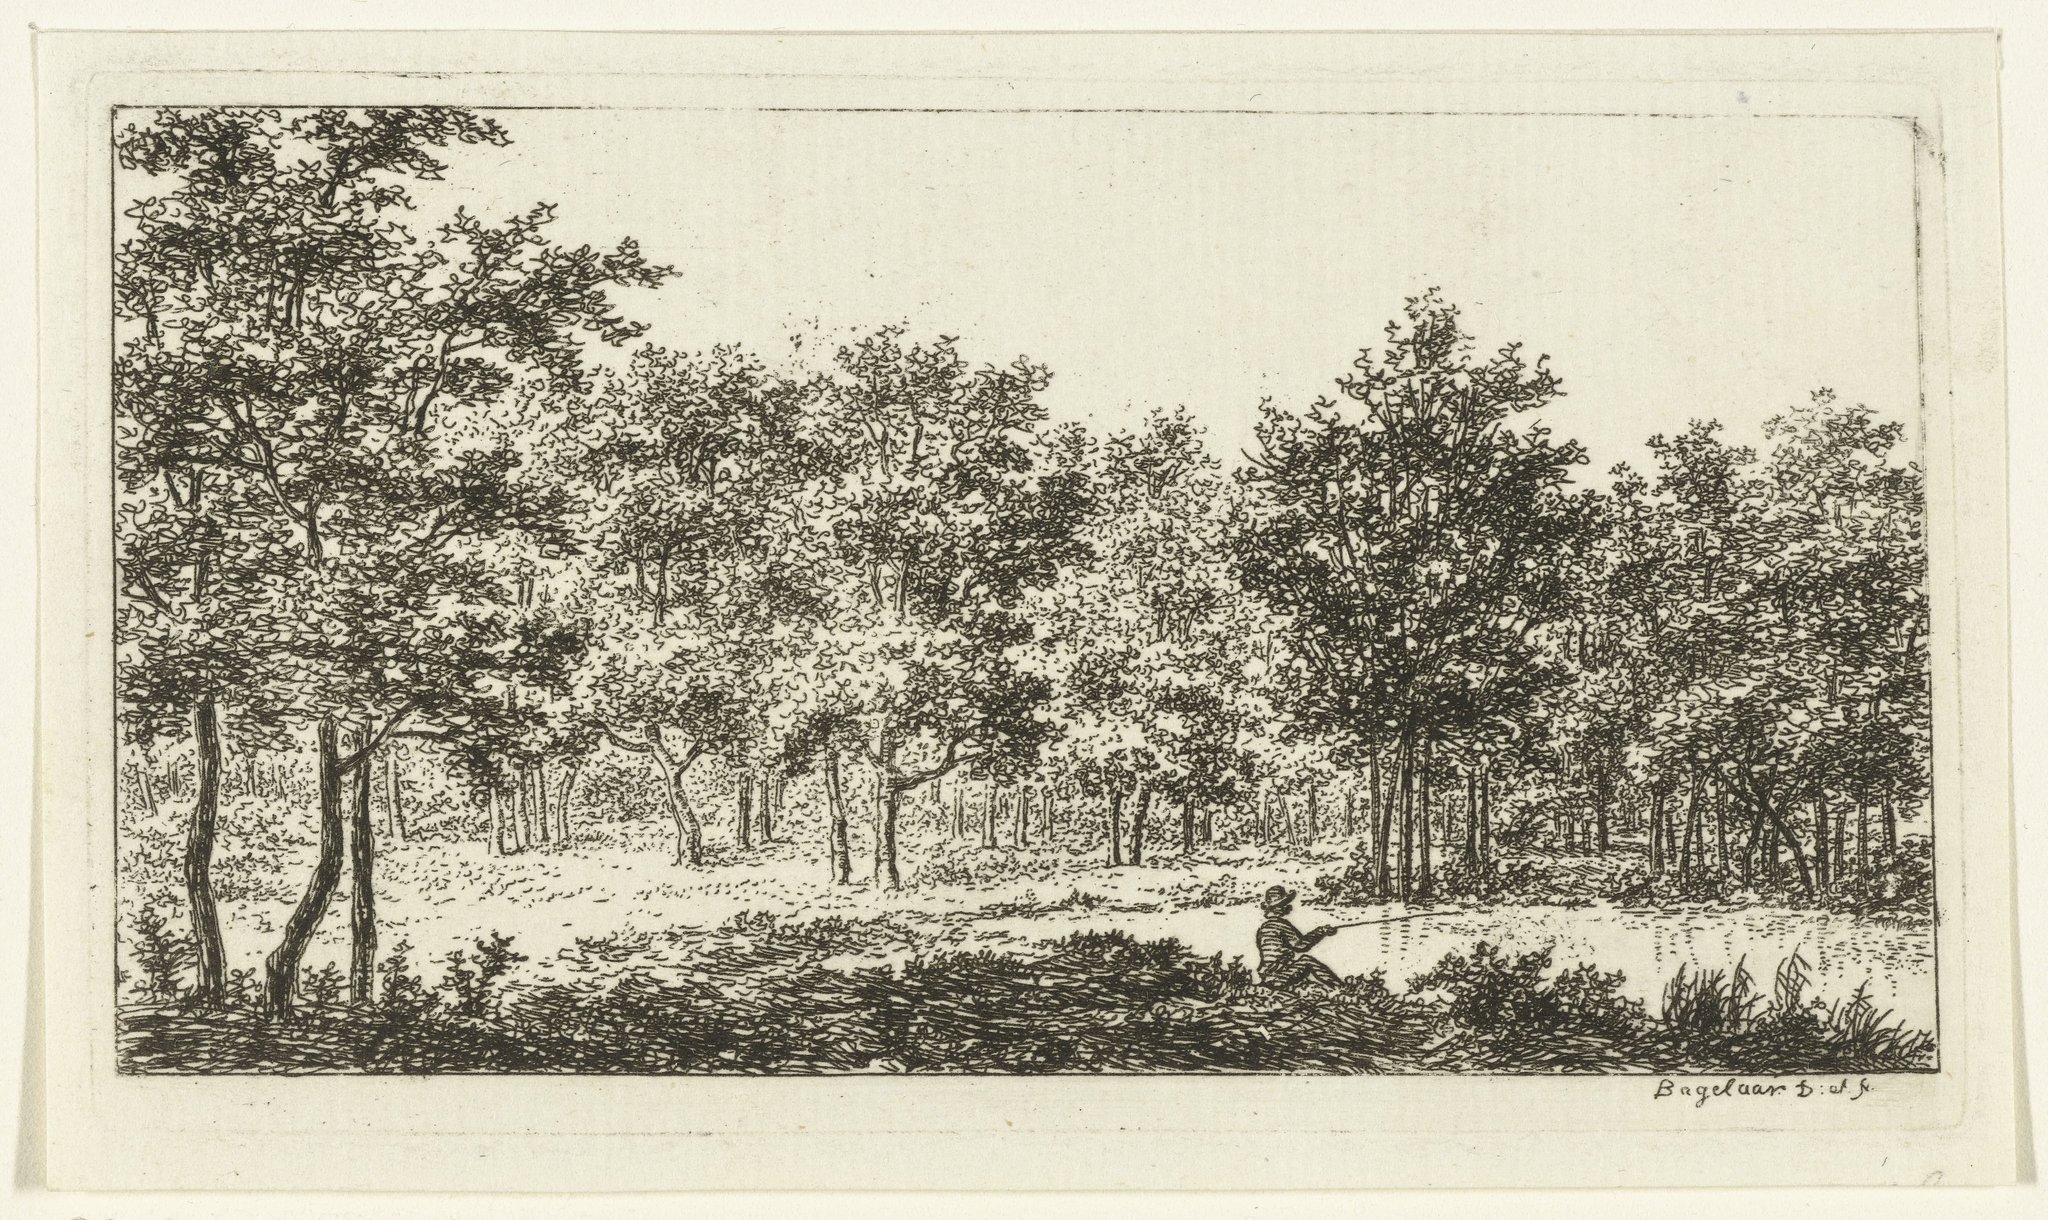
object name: print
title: Boslandschap met rivier en visser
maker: ernst willem jan bagelaar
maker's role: draughtsman, print maker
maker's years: 1775-1837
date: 1798-1837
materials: paper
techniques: etching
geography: netherlands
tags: forest, wood (+ landscape with figures, staffage)